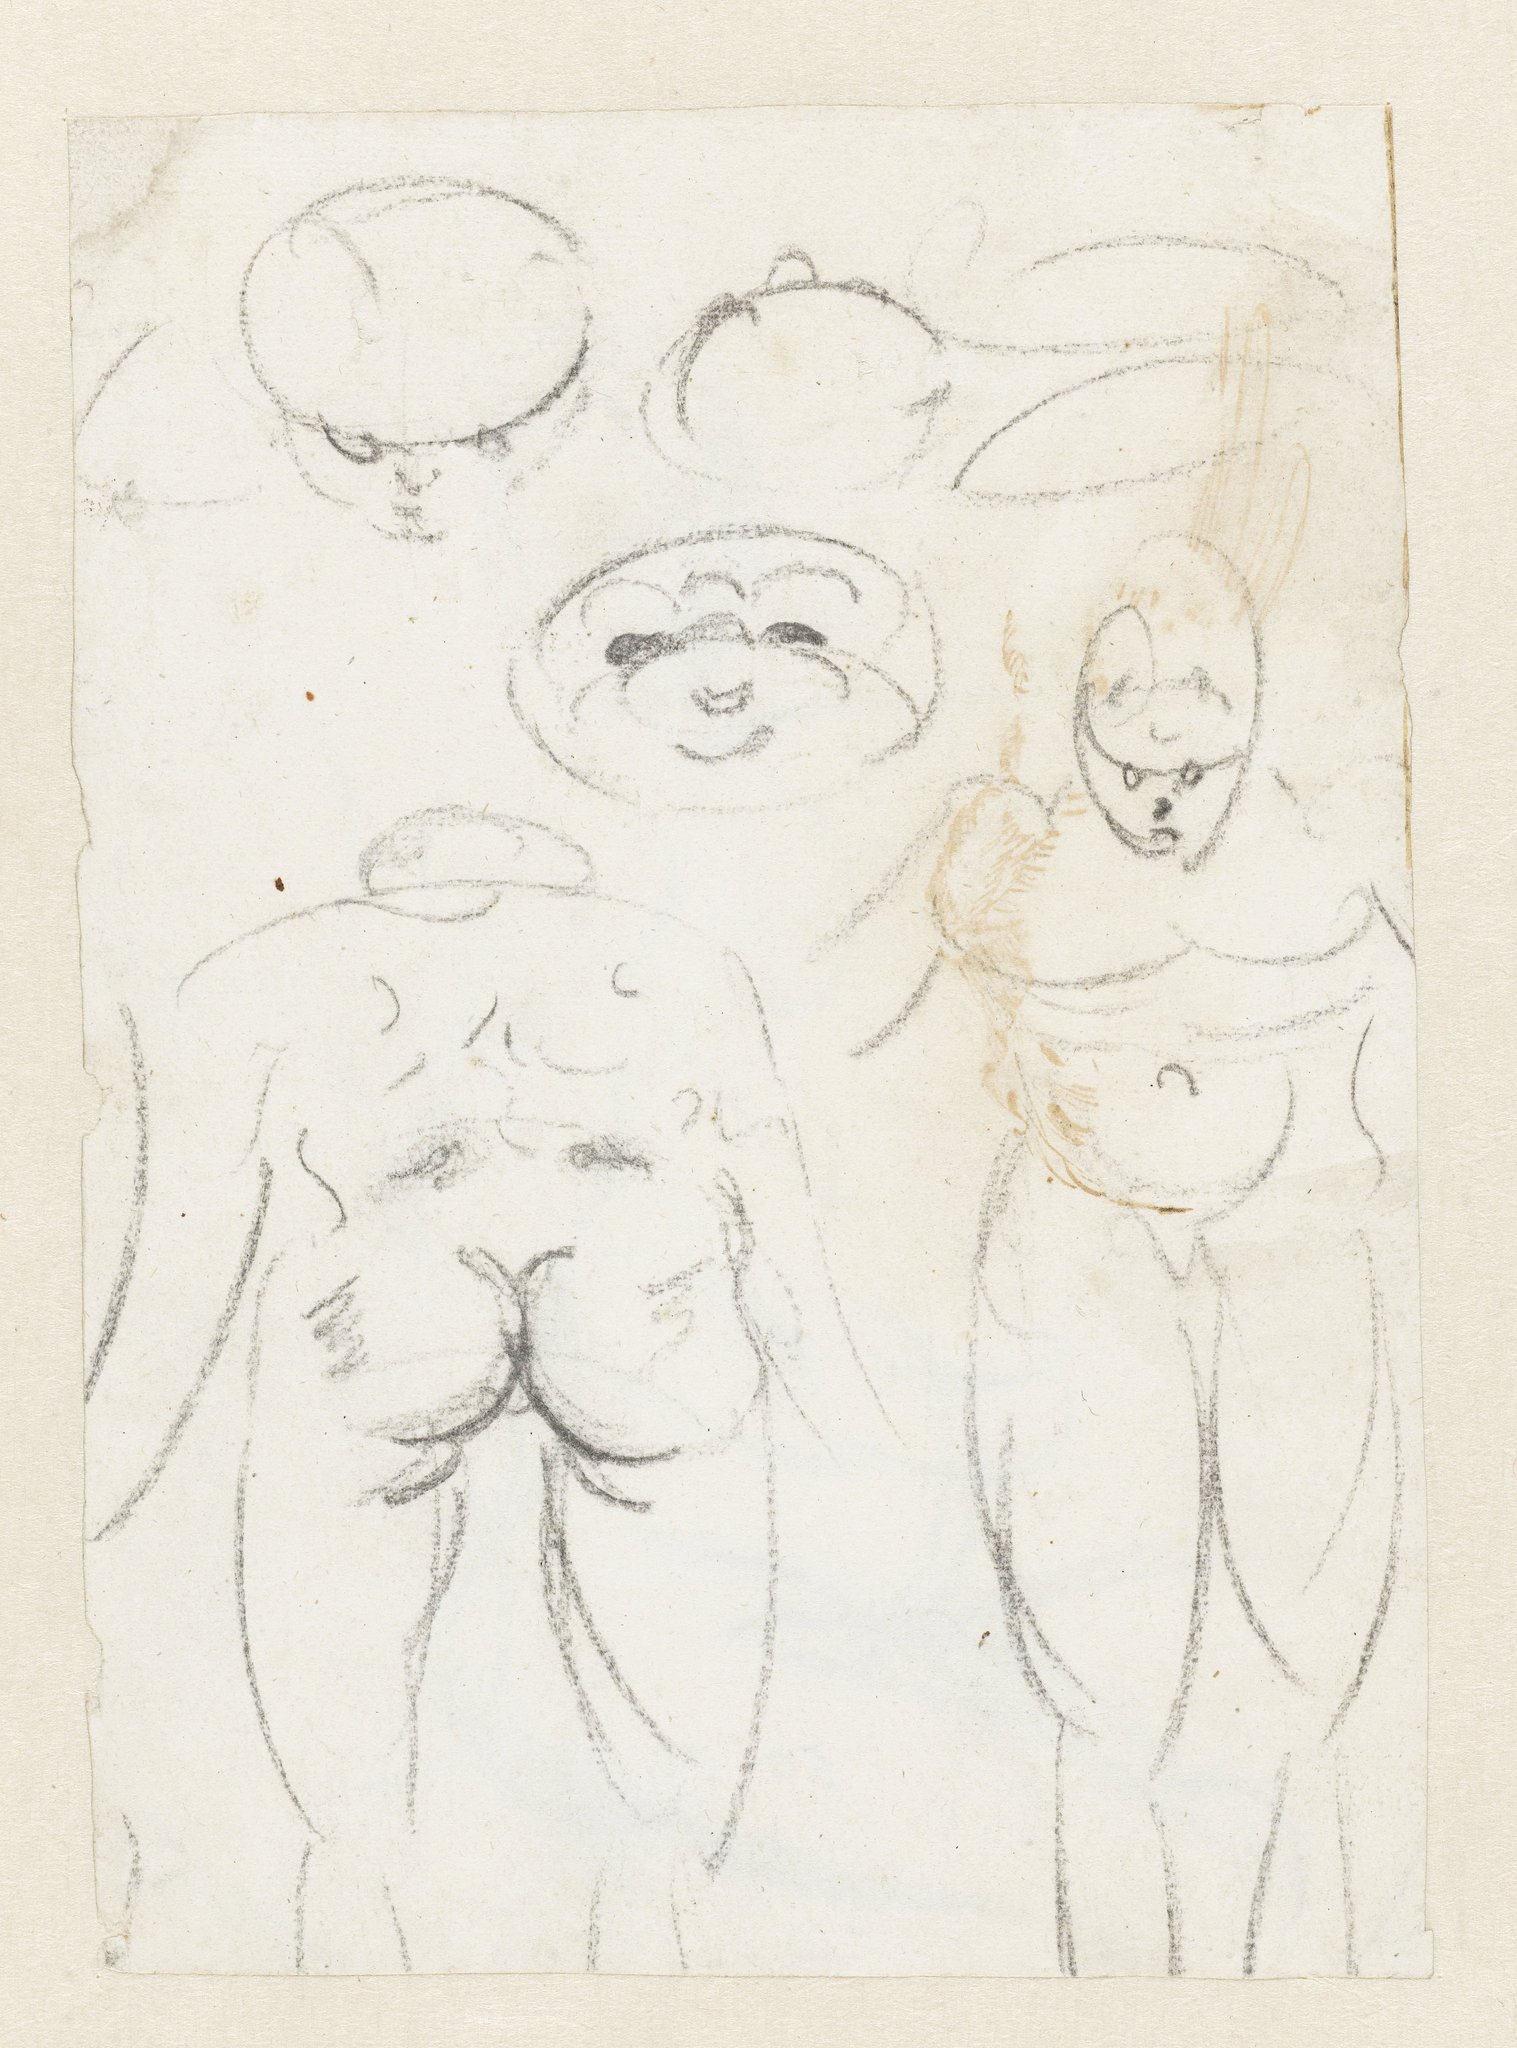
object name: drawing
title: Studies van figuren in het verkort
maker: jurriaan andriessen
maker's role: draughtsman, painter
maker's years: 1742-1819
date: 1752-1819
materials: chalk, paper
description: Schetsblad met studies van figuren in het verkort.